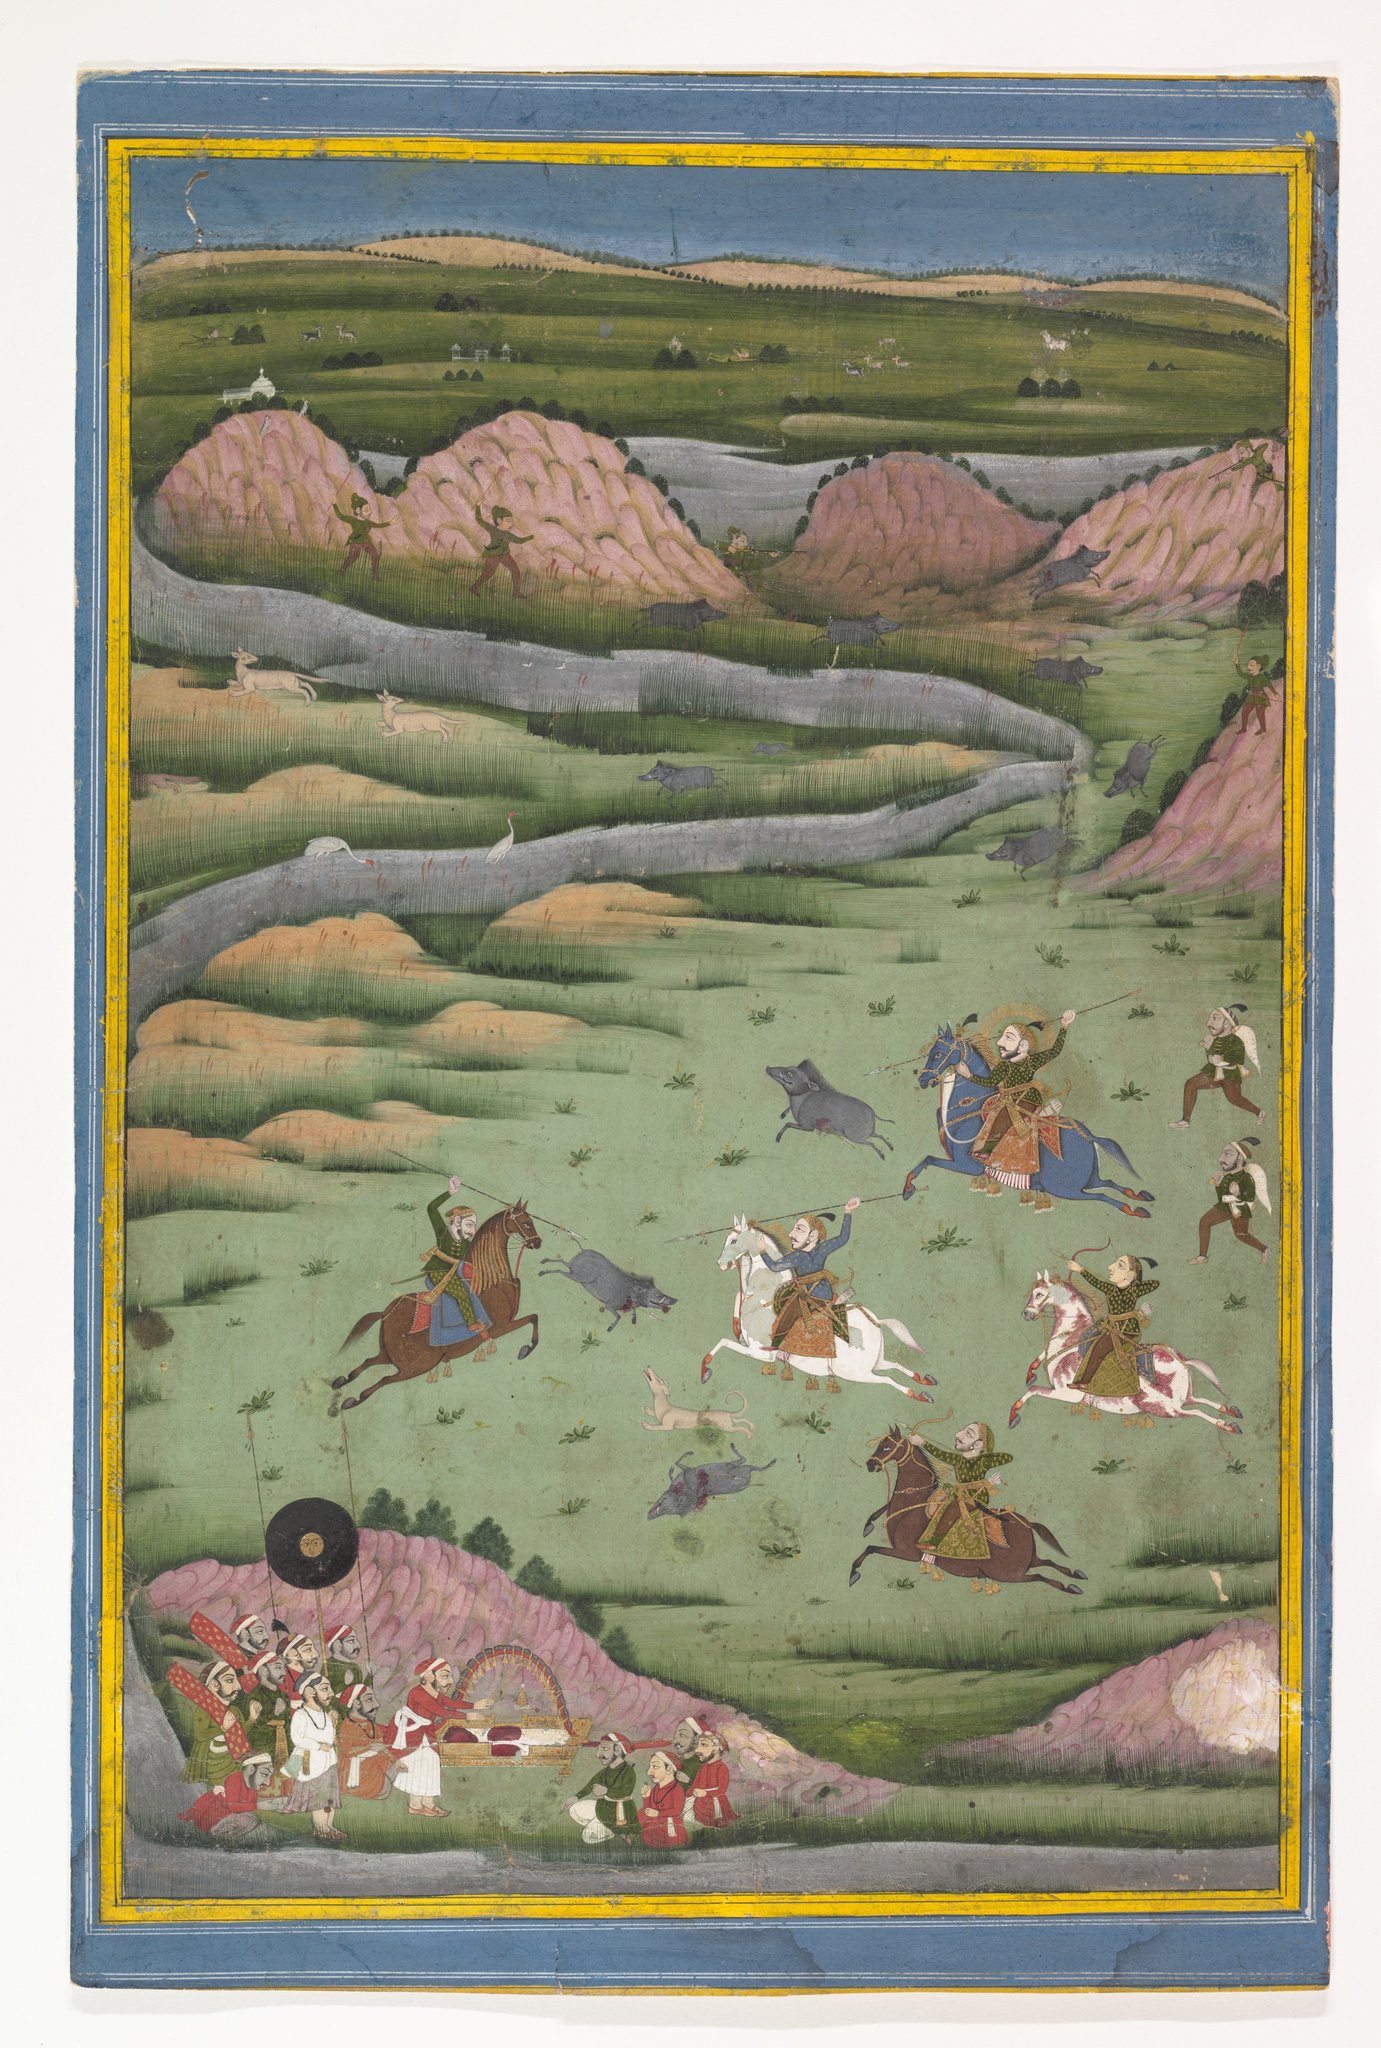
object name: painting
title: Maharana Amar Singh II or Sangram Singh Hunting Wild Boar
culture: western indian, rajasthan, udaipur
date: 1801-1900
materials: ink, paper, watercolor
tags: men,hunting,boars,horses,landscapes